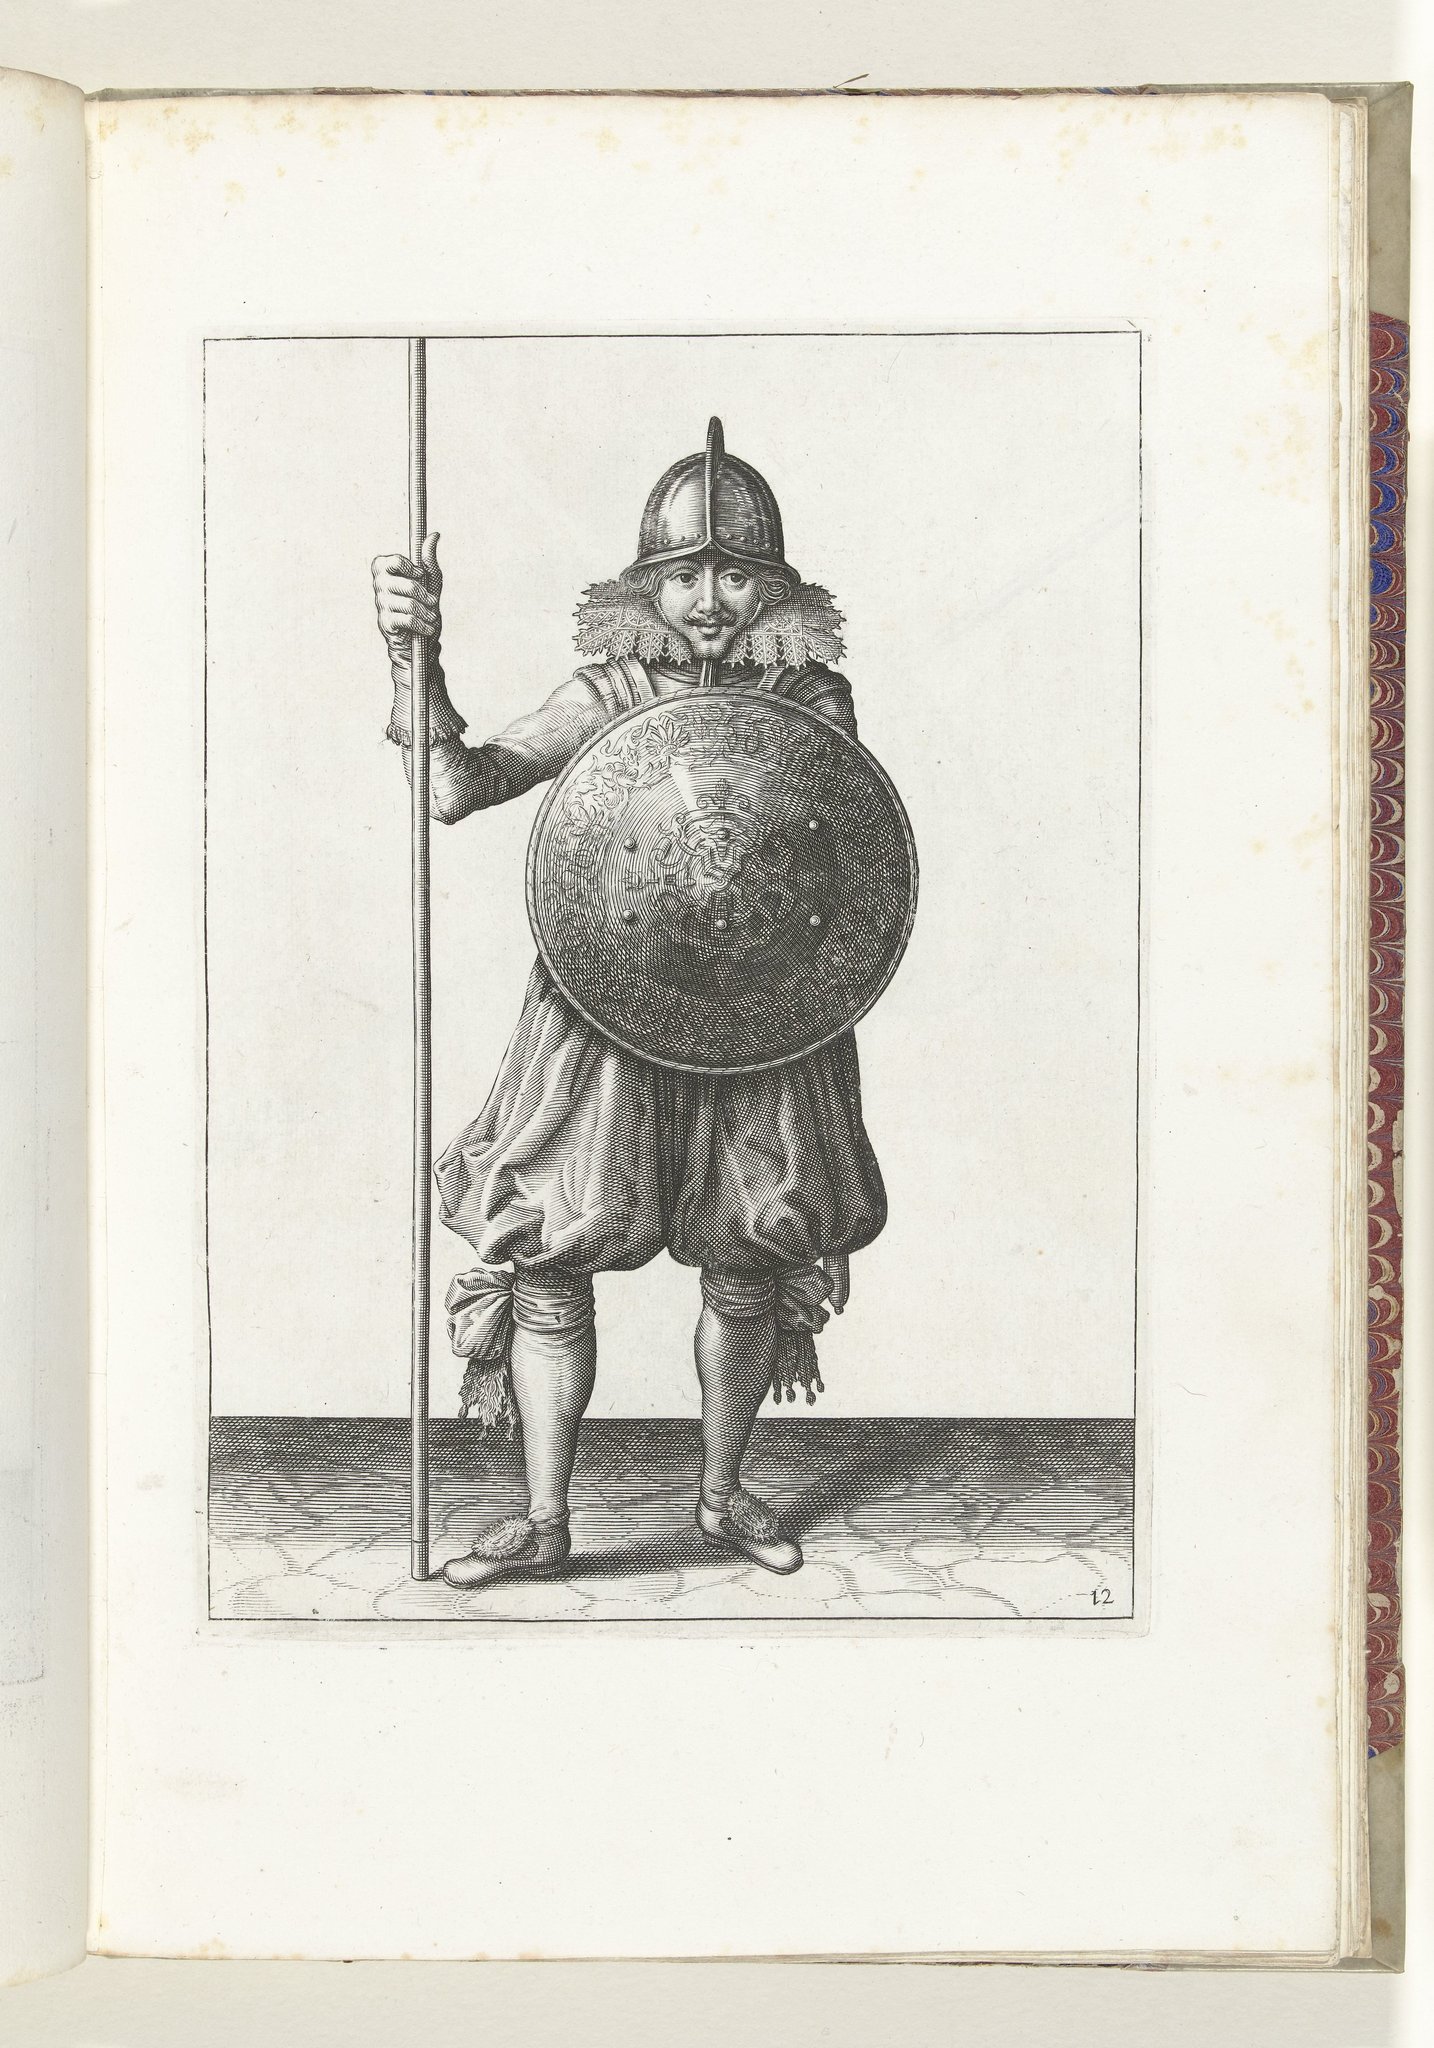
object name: print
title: De exercitie met schild en spies: de soldaat brengt in drie tijden de spies weer terug in de rustpositie, derde beweging (nr. 12), 1618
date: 1616-1618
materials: paper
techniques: engraving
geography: the hague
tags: maurice (prince of orange), handling of weapons ~ military training, weapons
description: Illustratie in: Adam van Breen, De Nassausche Wapen-Handelinge, van Schilt, Spies, Rappier ende Targe : beyde figuerlick afgebeelt, ende gestelt na de nieu ordening [van] ... Maurits van Nassau, 's-Gravenhage, [Aert Meuris] 1618, plaat nr. 12. In het exemplaar in de collectie van de Rijksmuseum Research Library (326 F 22).